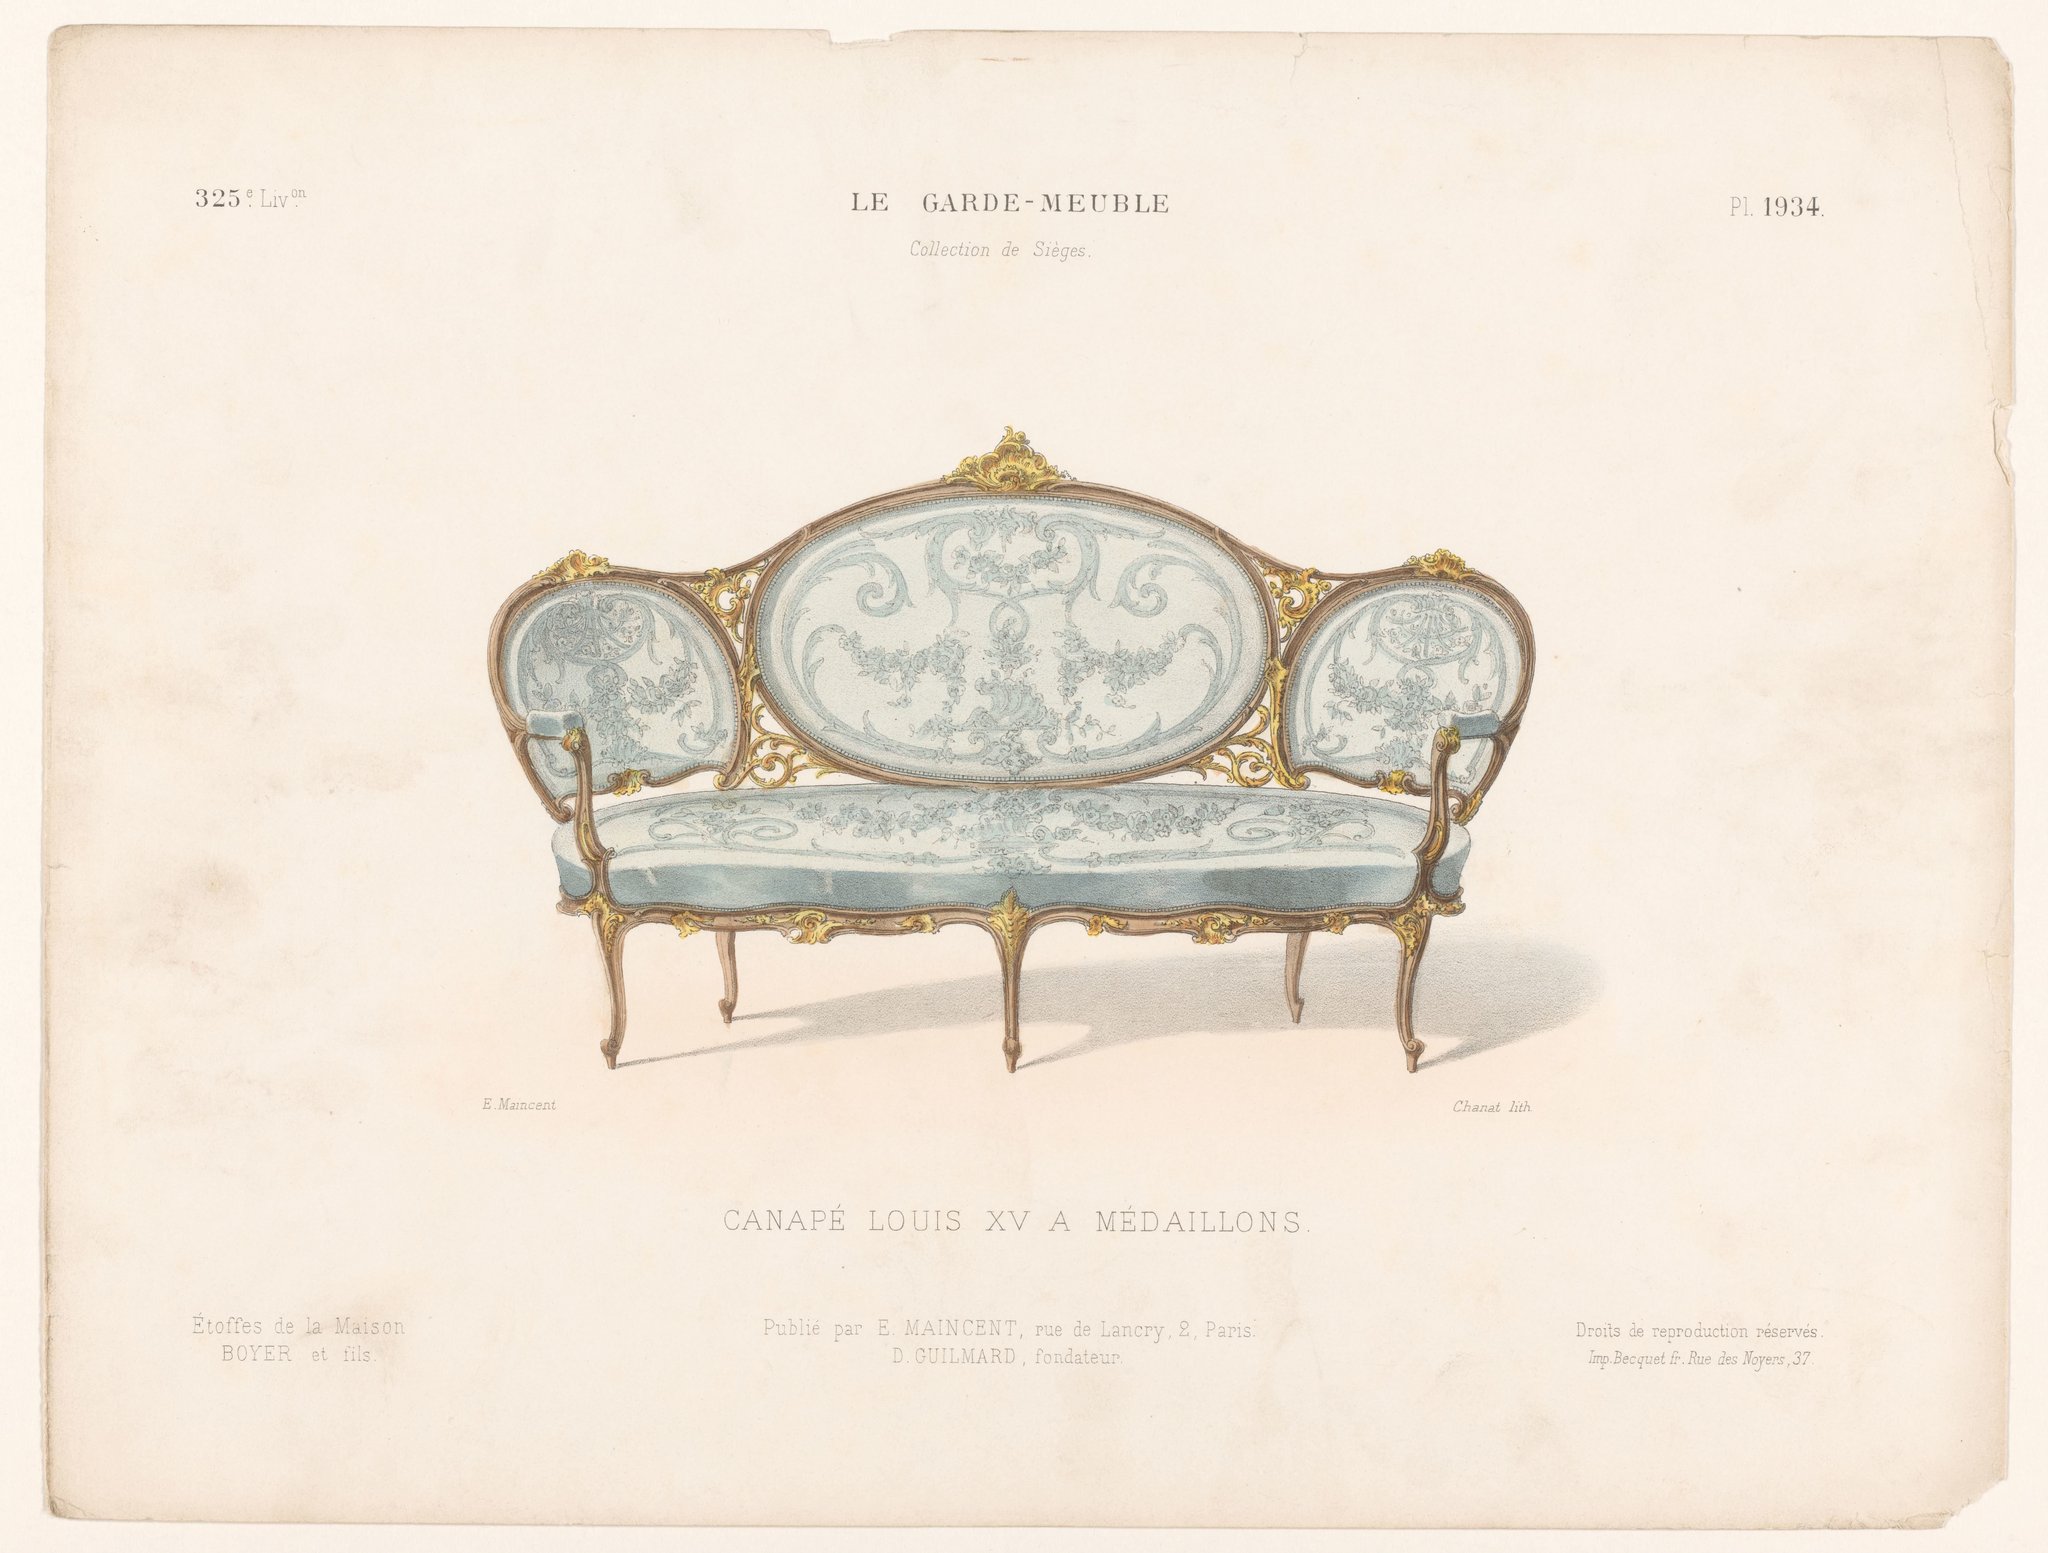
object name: print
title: Canapé Louis XV a medaillons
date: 1885-1895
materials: paper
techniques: hand coloring, lithograph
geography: paris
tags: seating furniture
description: Ieder Livraison in de serie Le Garde-Meuble bevat negen platen: drie 'sièges' (zitmeubels), drie 'meubles' (diverse meubels zoals tafels en kasten) en drie 'tentures' (gordijnen en draperieën).